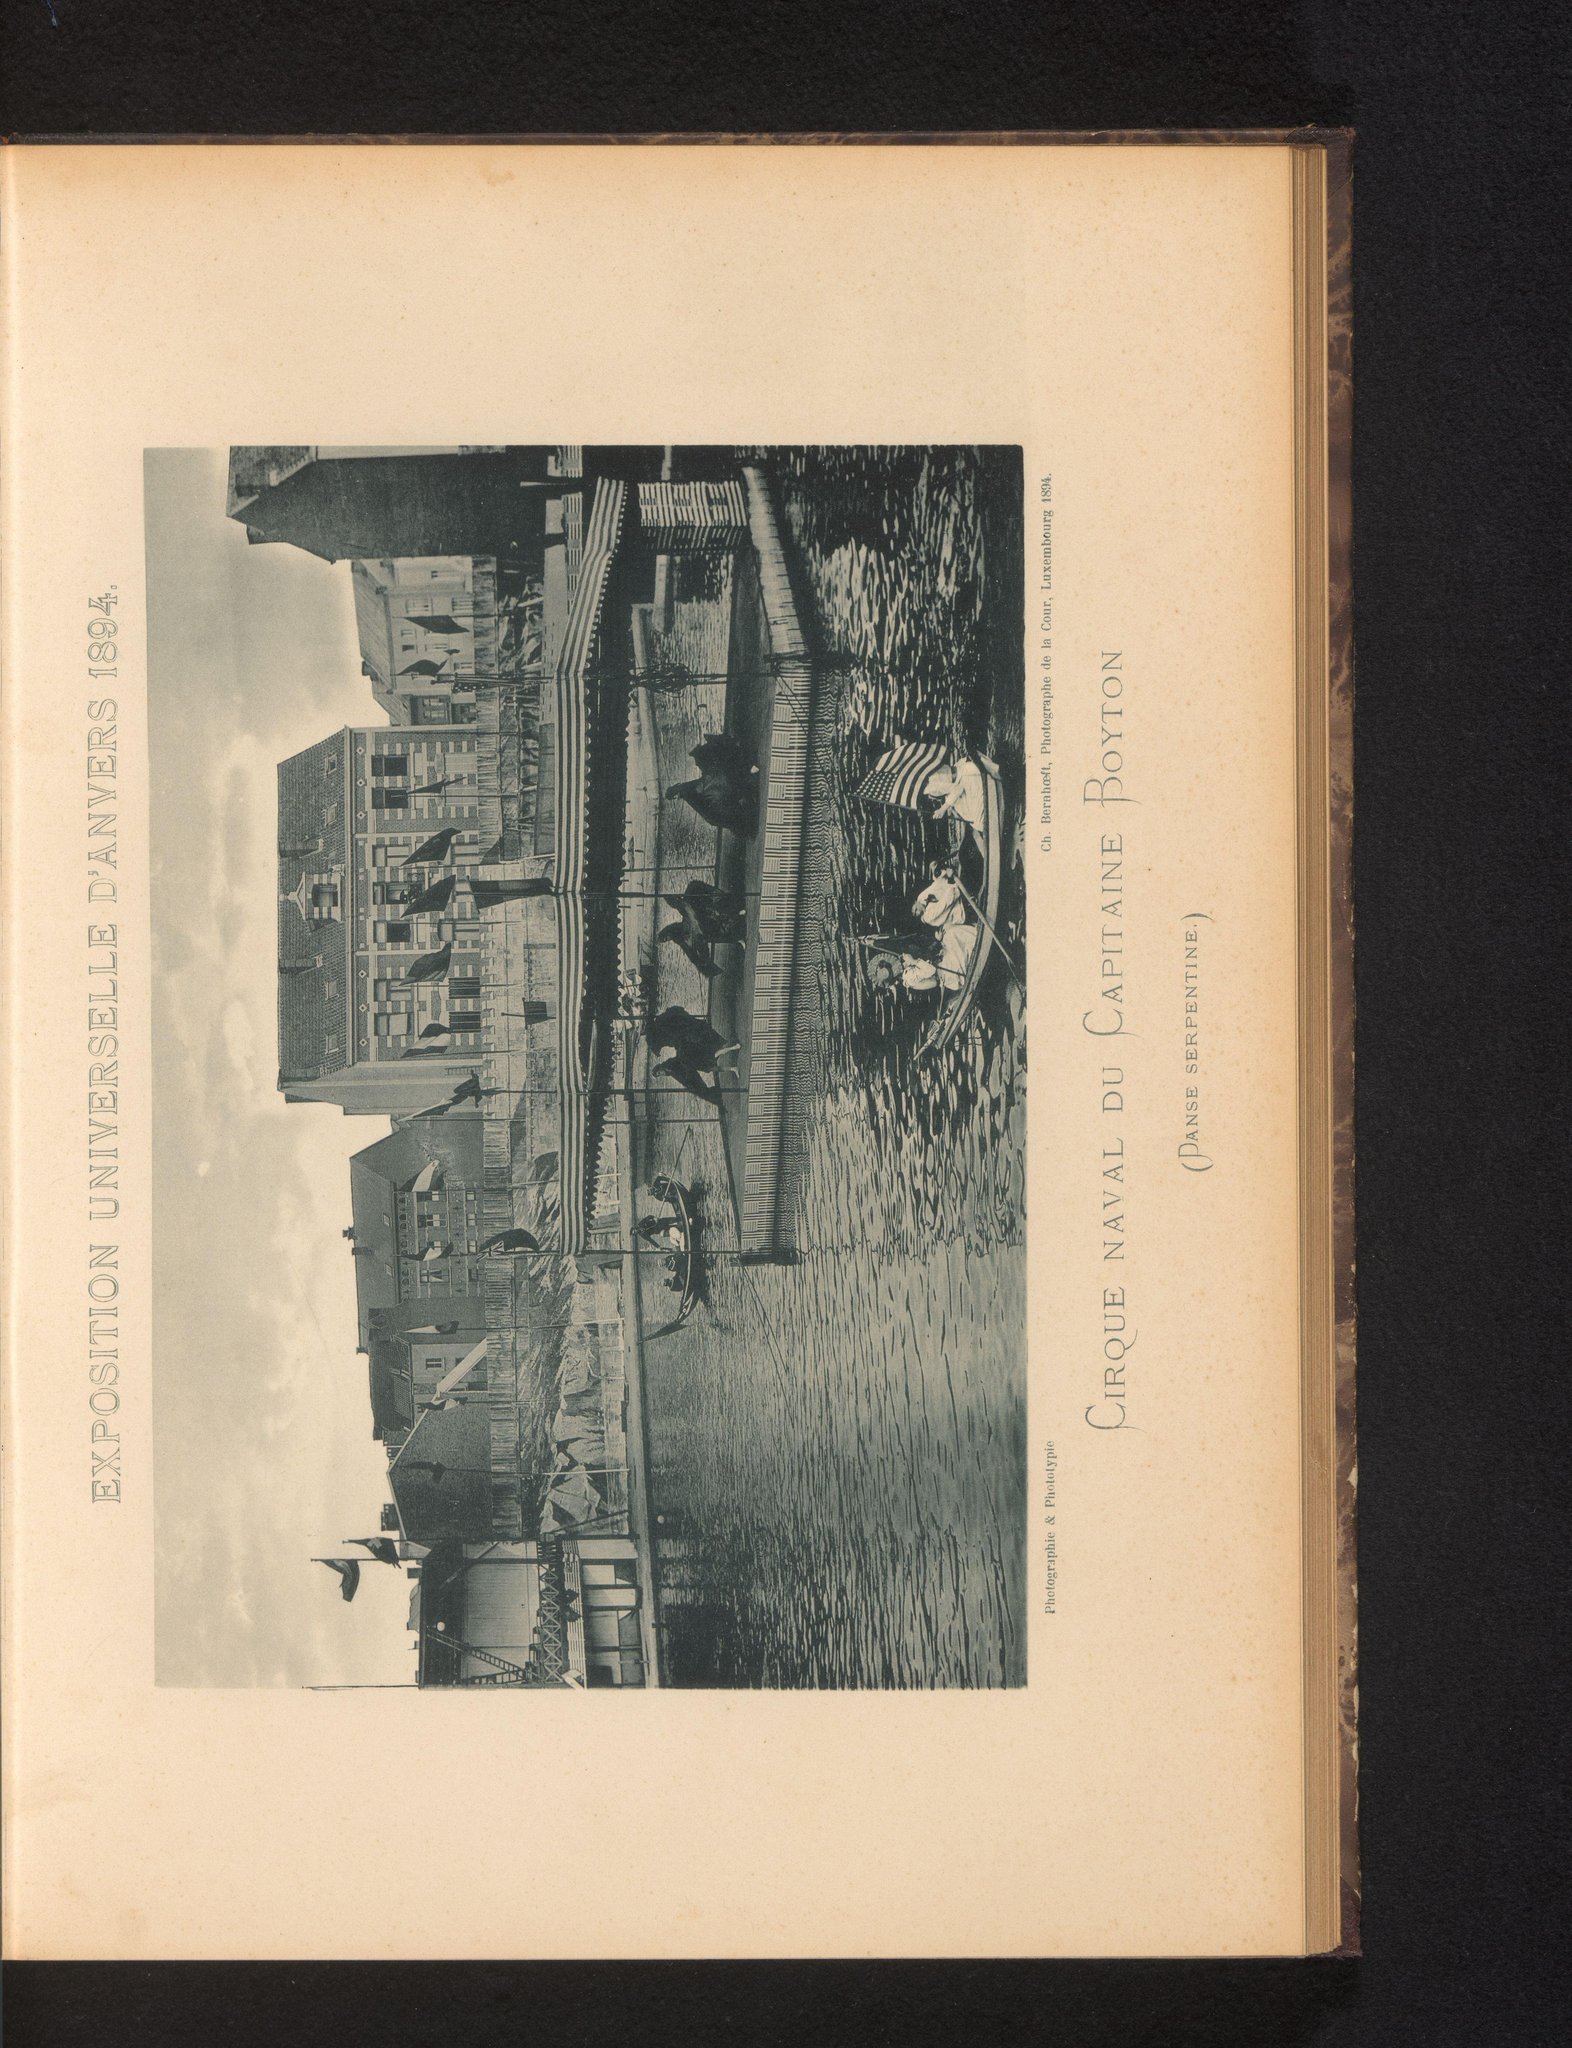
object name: page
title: Cirque naval du Captaine Boyton (Danse serpentine)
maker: charles bernhoeft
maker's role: publisher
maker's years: 1859-1933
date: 1894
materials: paper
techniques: photograph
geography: luxembourg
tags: world fair, world exhibition, rowing-boat, canoe, etc., circus, group dancing, antwerp